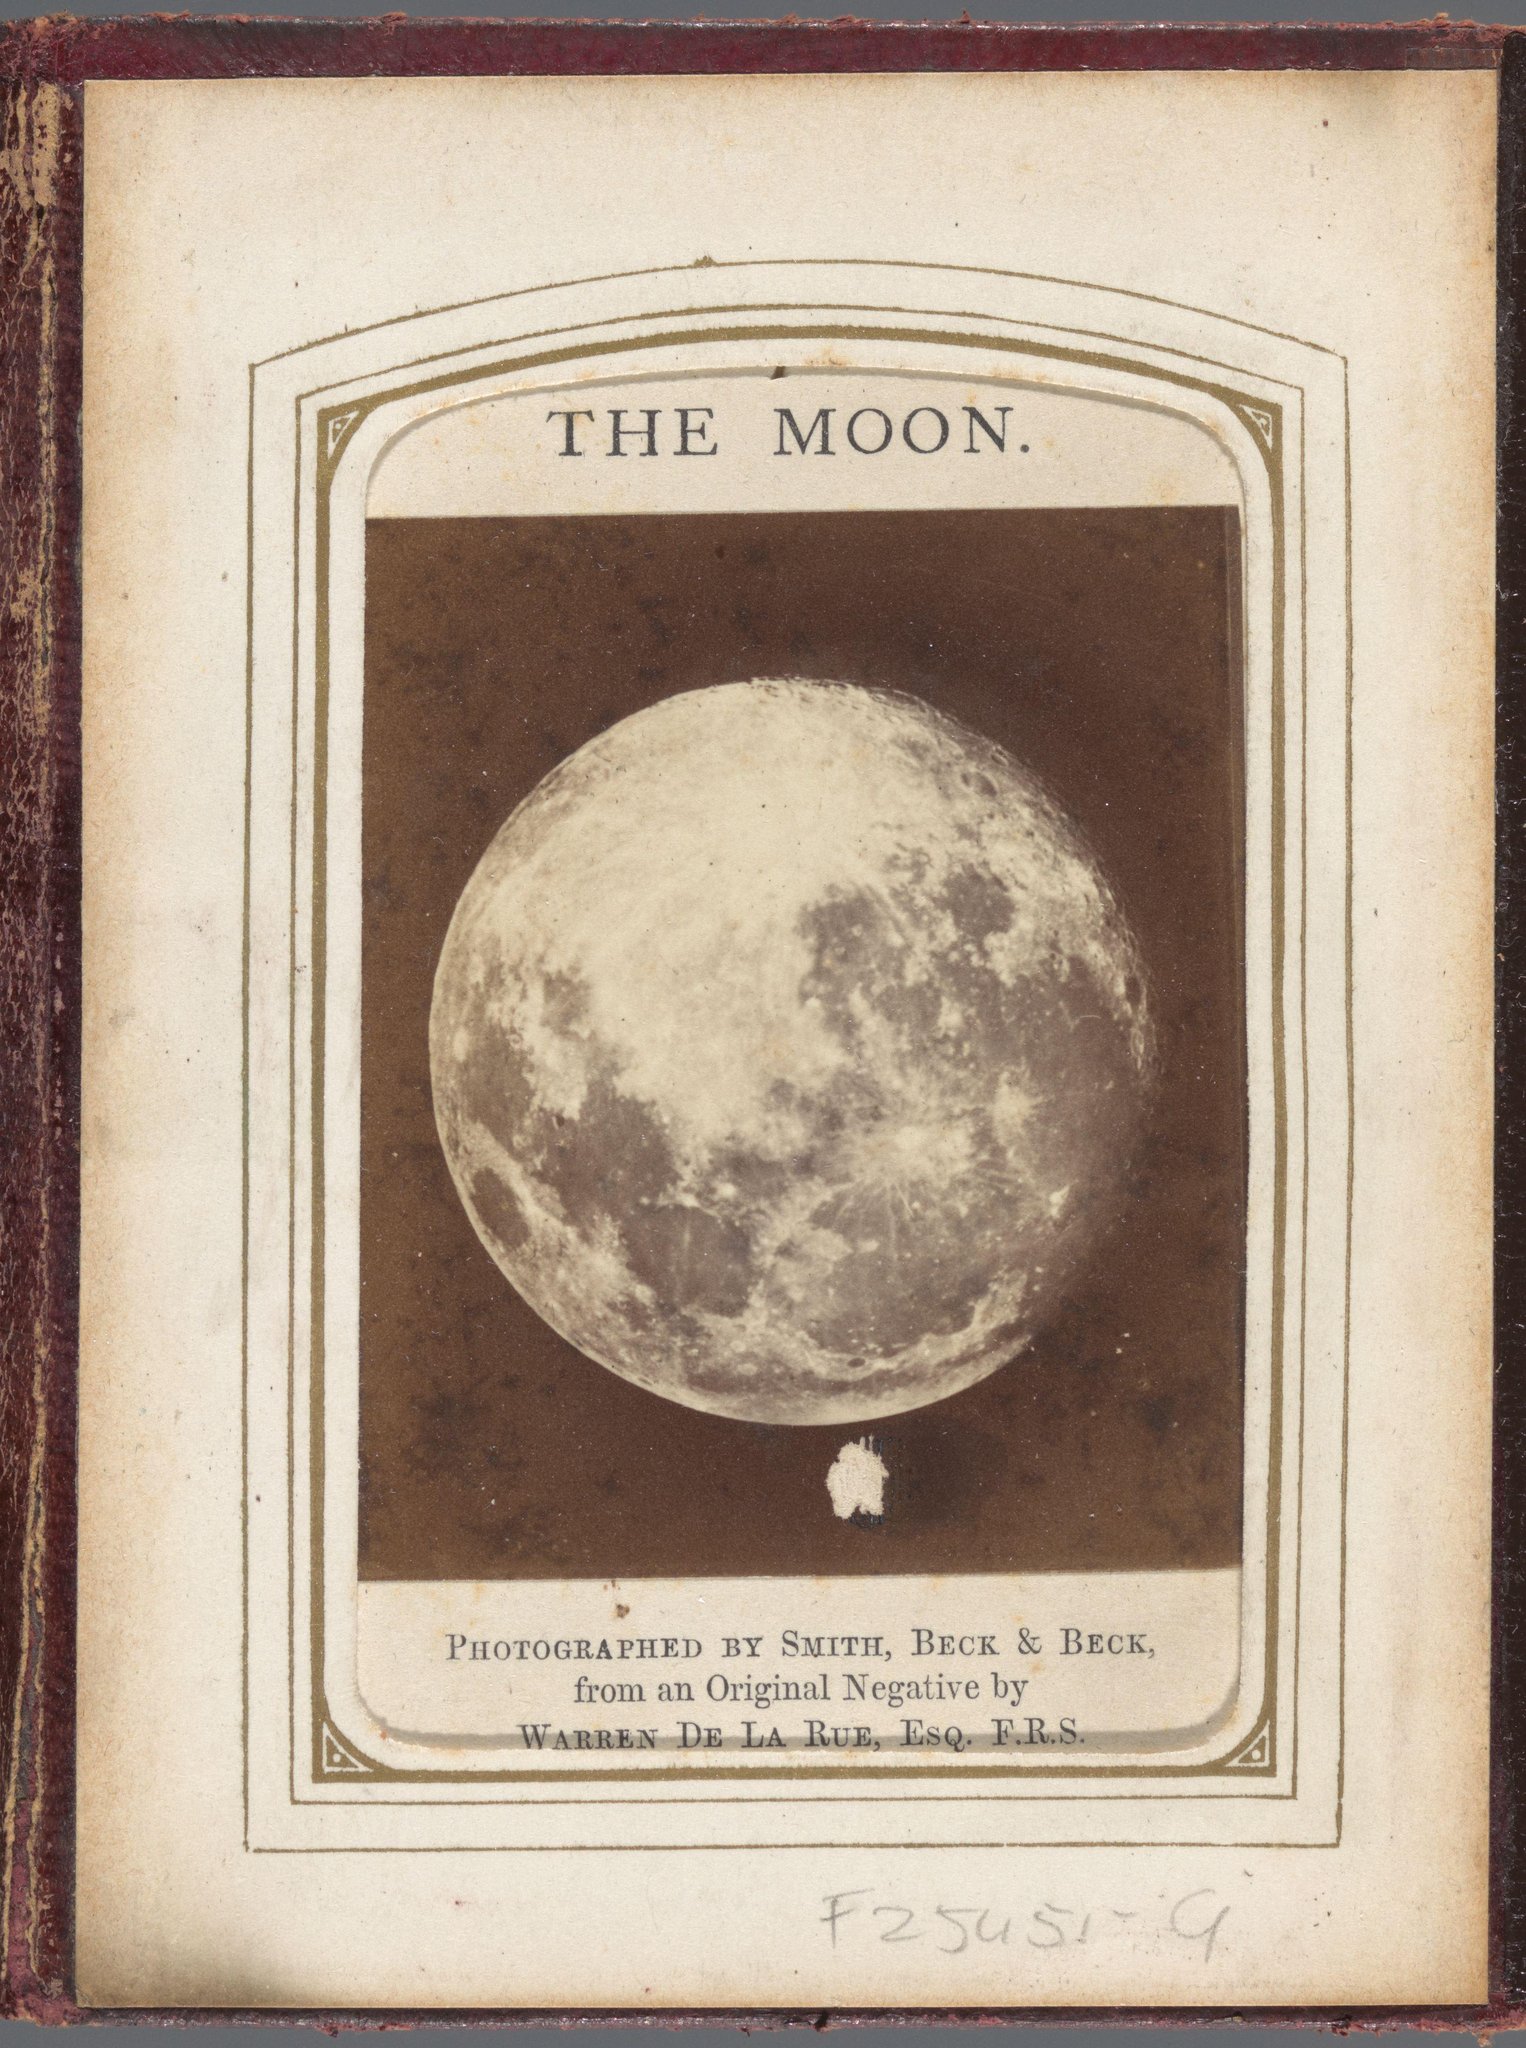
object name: photograph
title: The Moon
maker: warren de la rue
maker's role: astronoom, fotograaf, scheikundige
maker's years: 1815-1889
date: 1866-1880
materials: cardboard, paper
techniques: albumen print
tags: waning moon, i.e. facing this way (, moon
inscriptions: inscription: ‘PHOTOGRAPHED BY SMITH, BECK & BECK,/ from an Original Negative by/WARREN DE LA RUE, ESQ, F.R.S.’